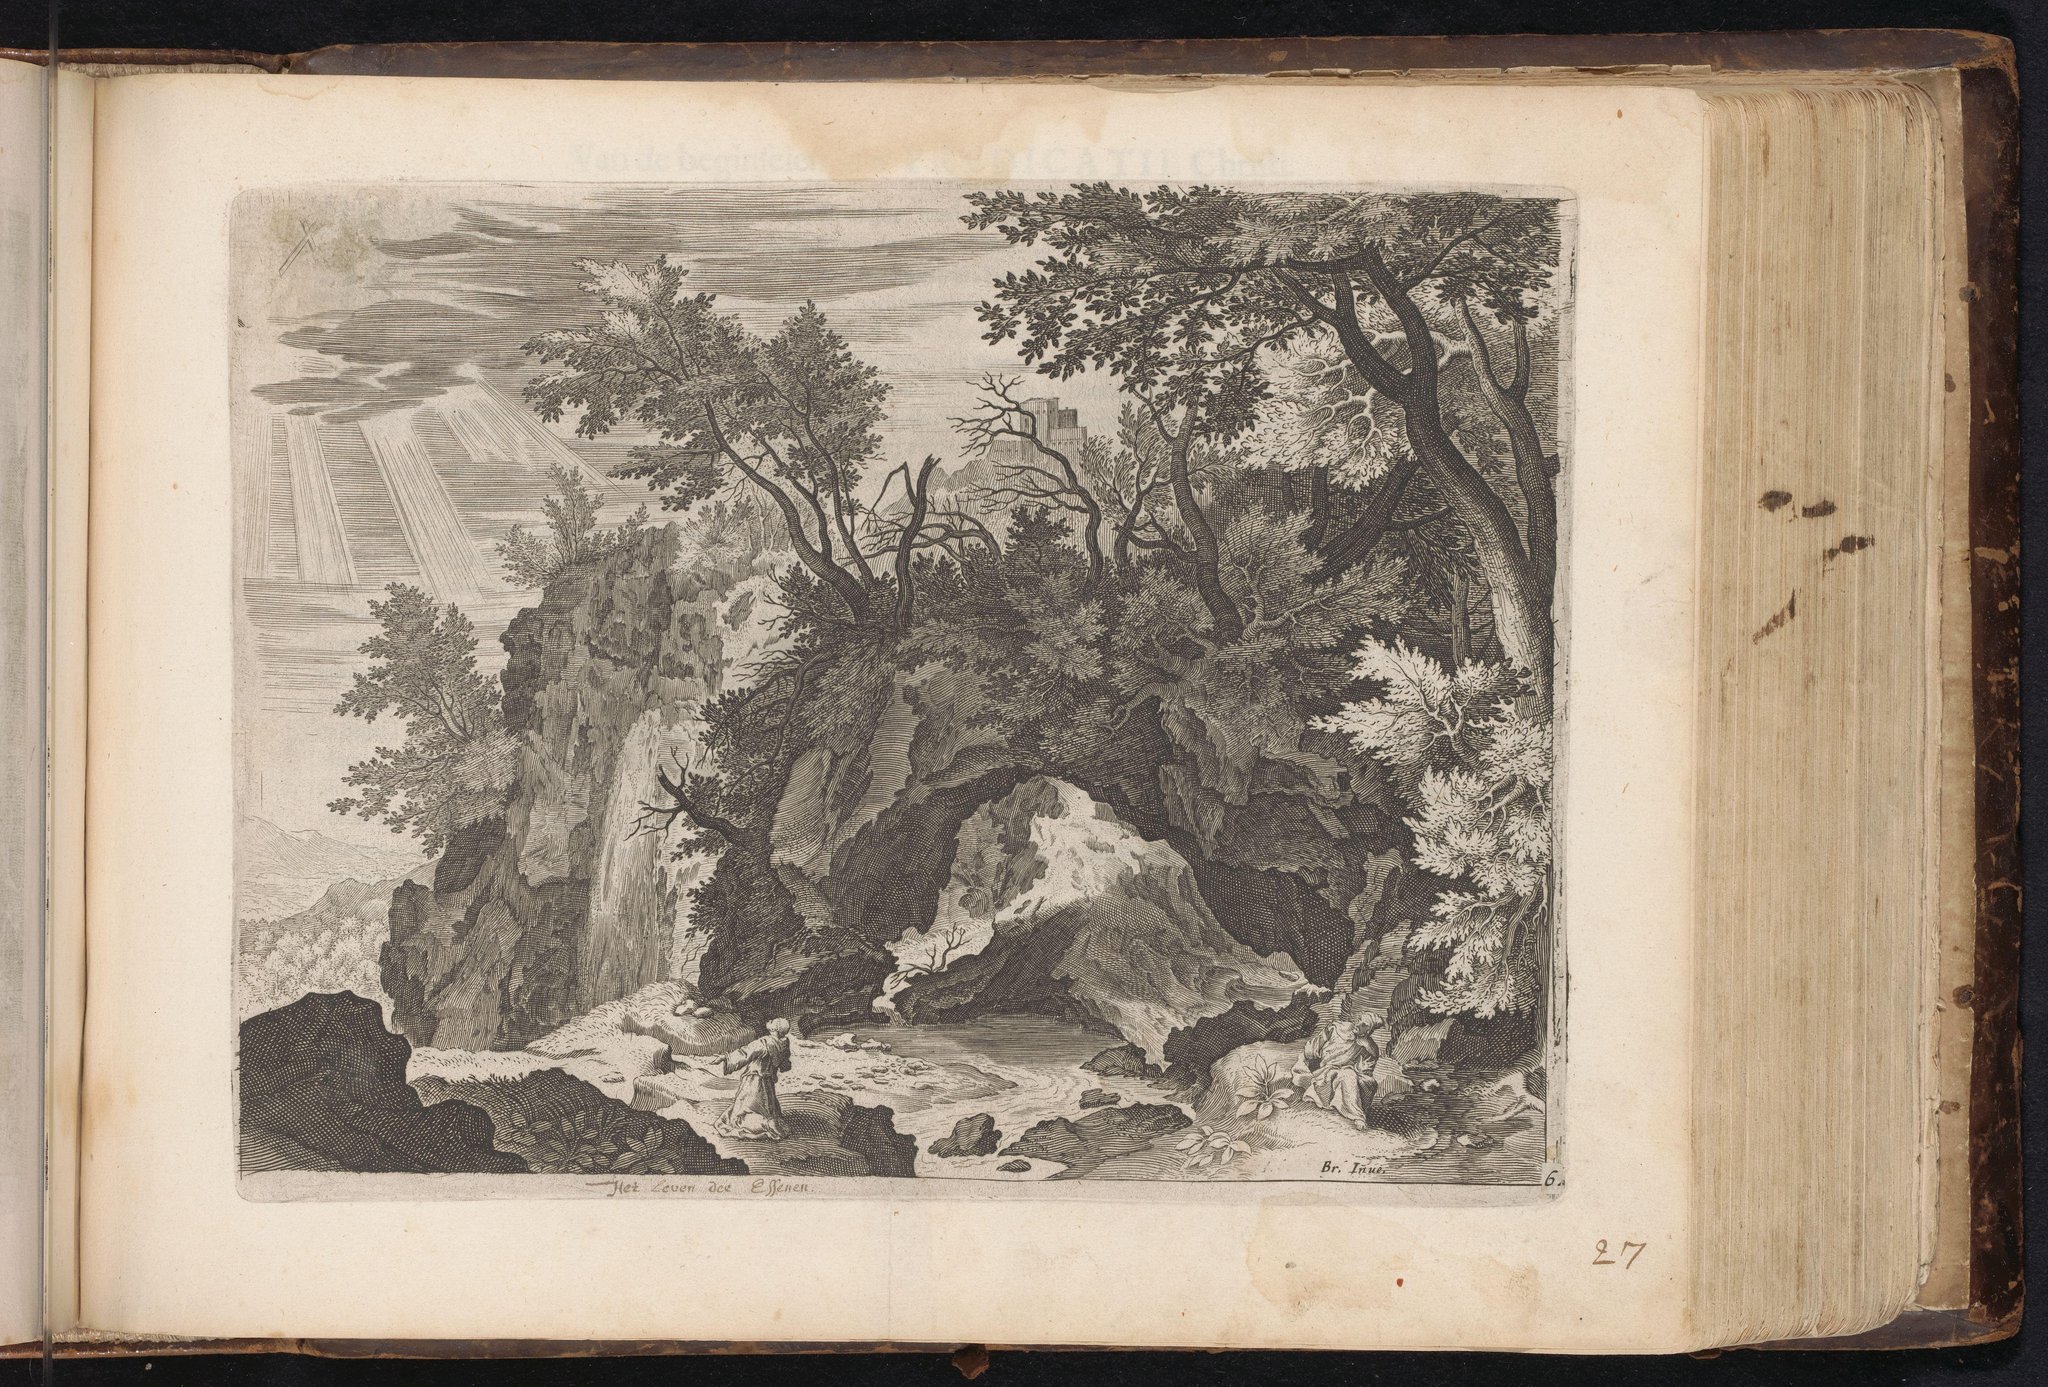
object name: album leaf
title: Den Grooten Figuer-Bibel (...)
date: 1580-1629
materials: paper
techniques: engraving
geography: alkmaar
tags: stigmatization of st. francis of assisi: in retreat on mount alverna, he beholds a vision of christ on the cross enveloped by wings (like a seraph with six wings); rays passing down to the body of the kneeling saint form the marks of the five wounds of christ, rocks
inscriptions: inscription: ‘Het Leven der Essenen’, serial number: ‘6’, number: ‘27’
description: Rotslandschap met bomen. Op de voorgrond links de Heilige Franciscus. Hij ziet in een visioen het kruis van Christus en ontvangt zijn stigmata. Rechts broeder Leo. In de context van het album en volgens het onderschrift illustreren zij het leven van de Essenen. Deze prent maakt deel uit van een album.